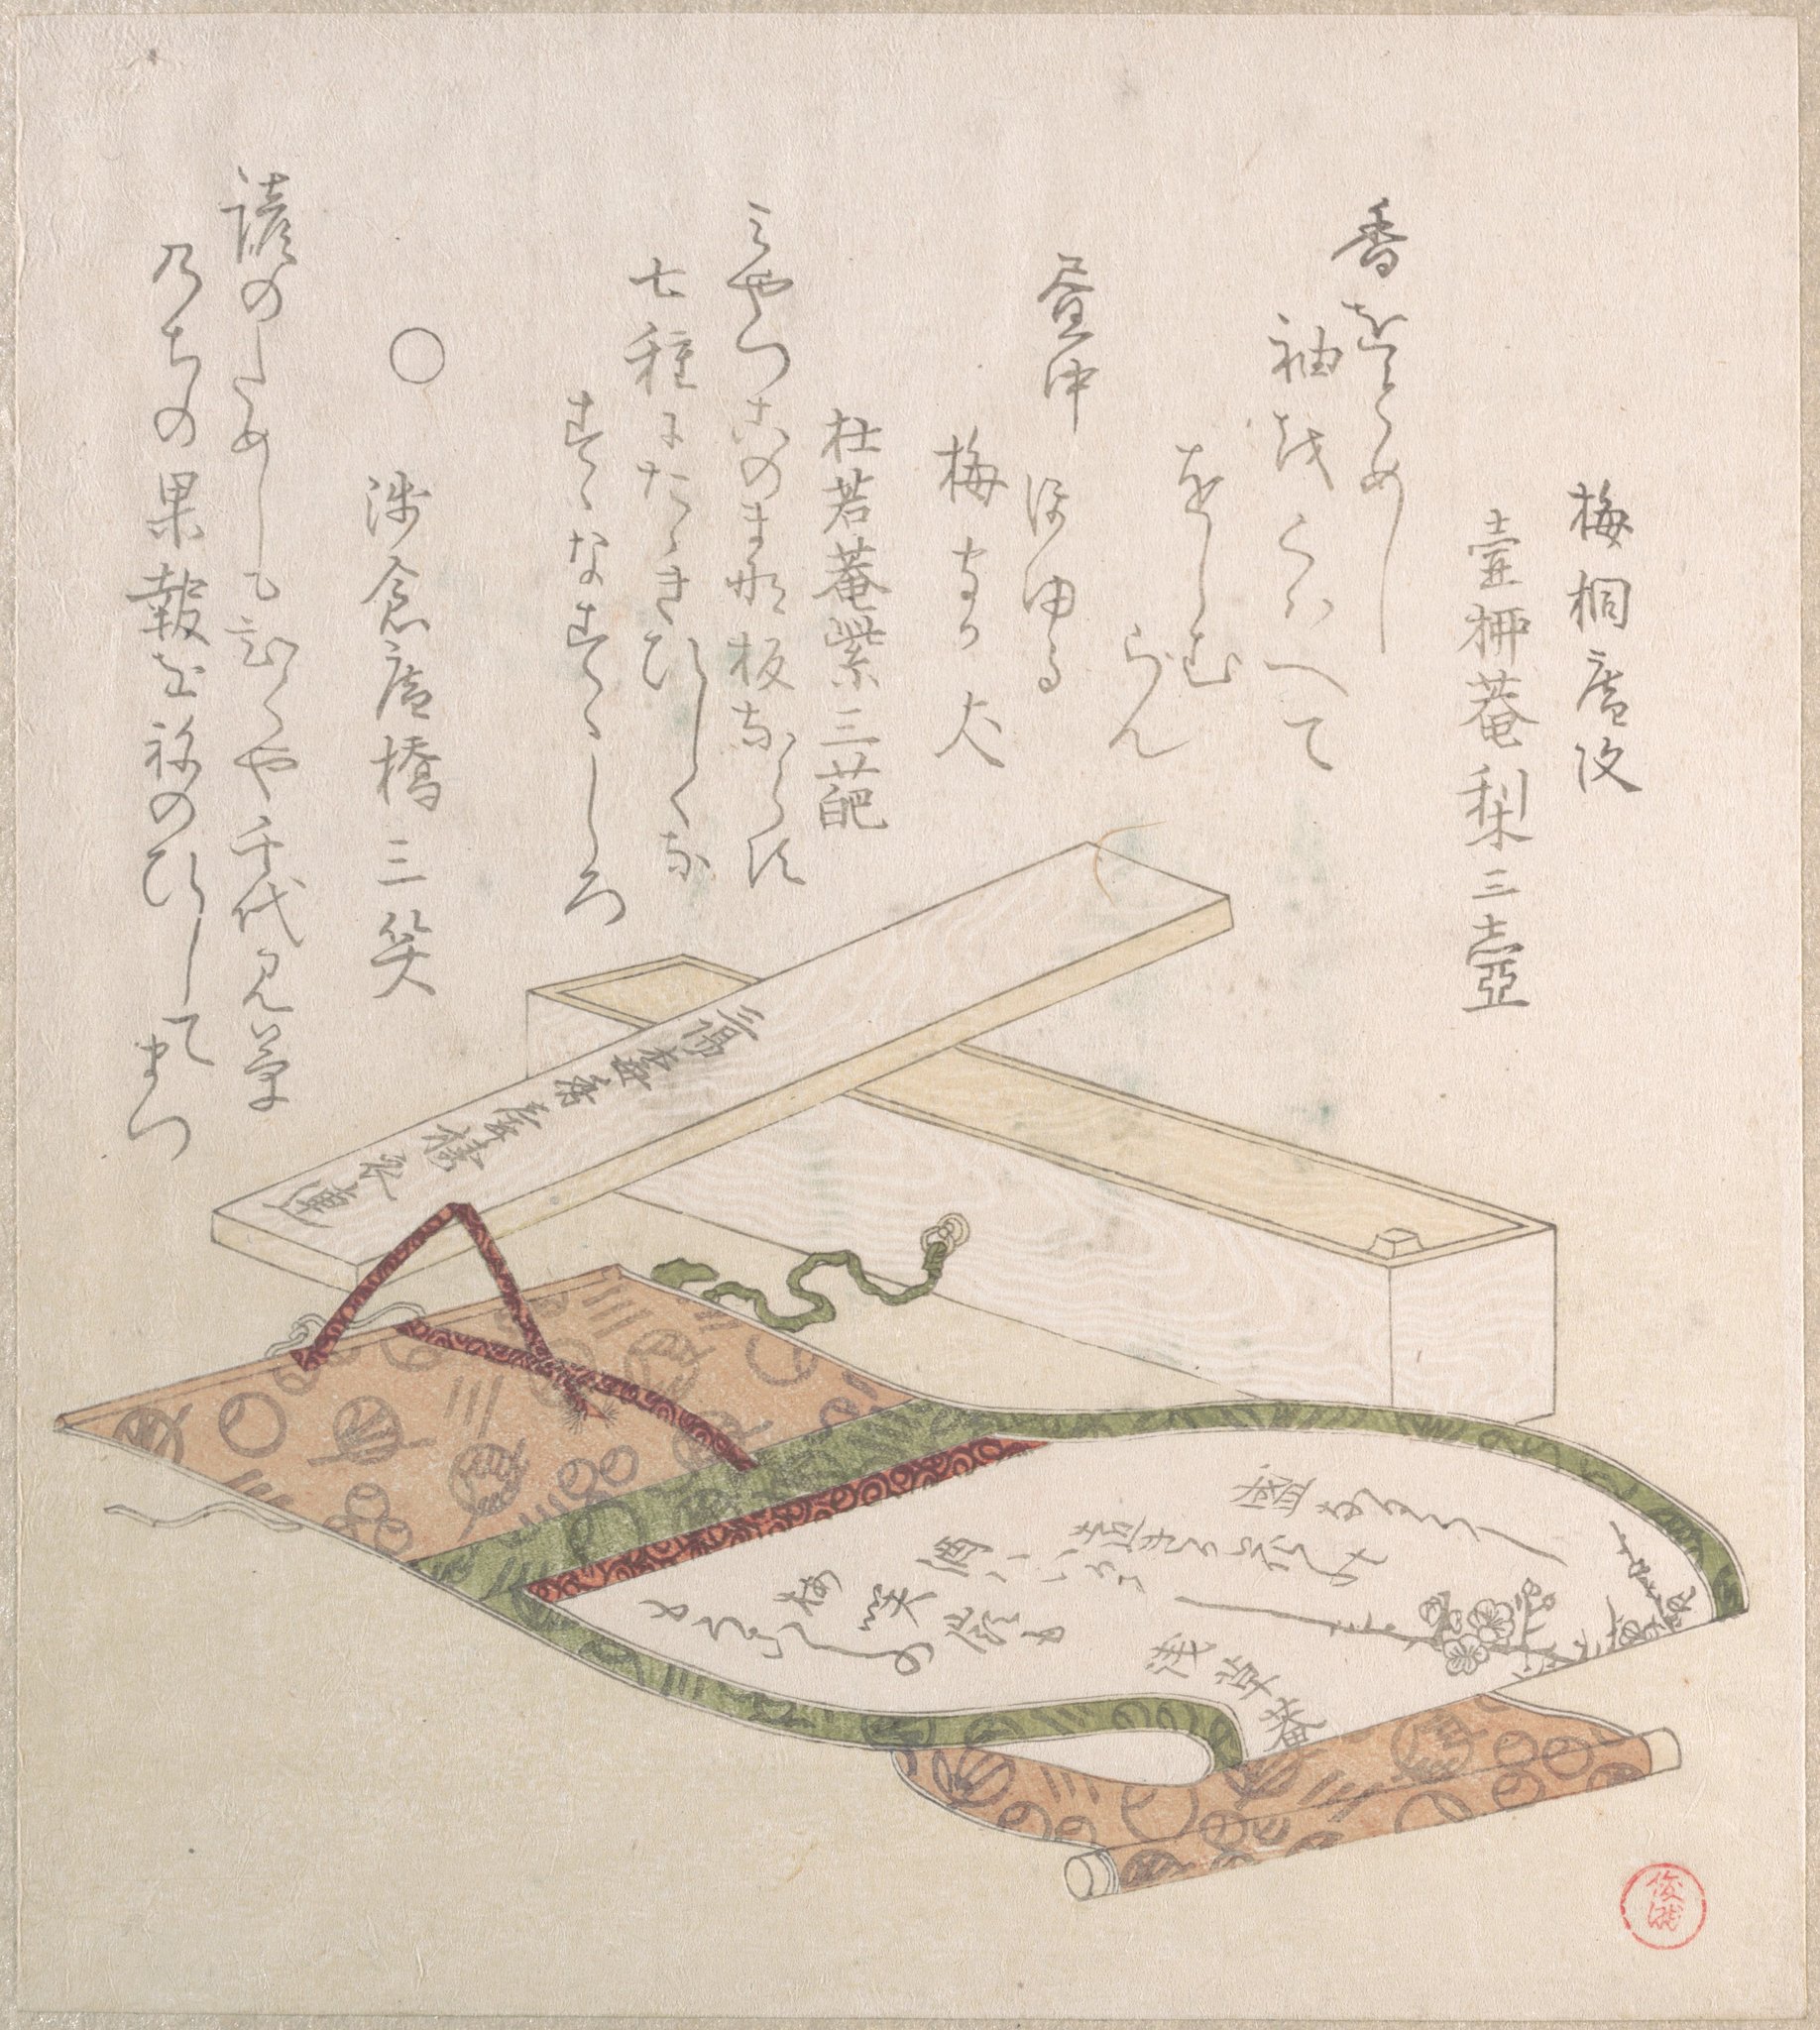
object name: woodblock print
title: Kakemono and Its Box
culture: japanese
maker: kubo shunman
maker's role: artist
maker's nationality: japanese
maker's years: 1757-1820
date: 1701-1900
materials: ink, paper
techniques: surimono, woodblock print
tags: scrolls